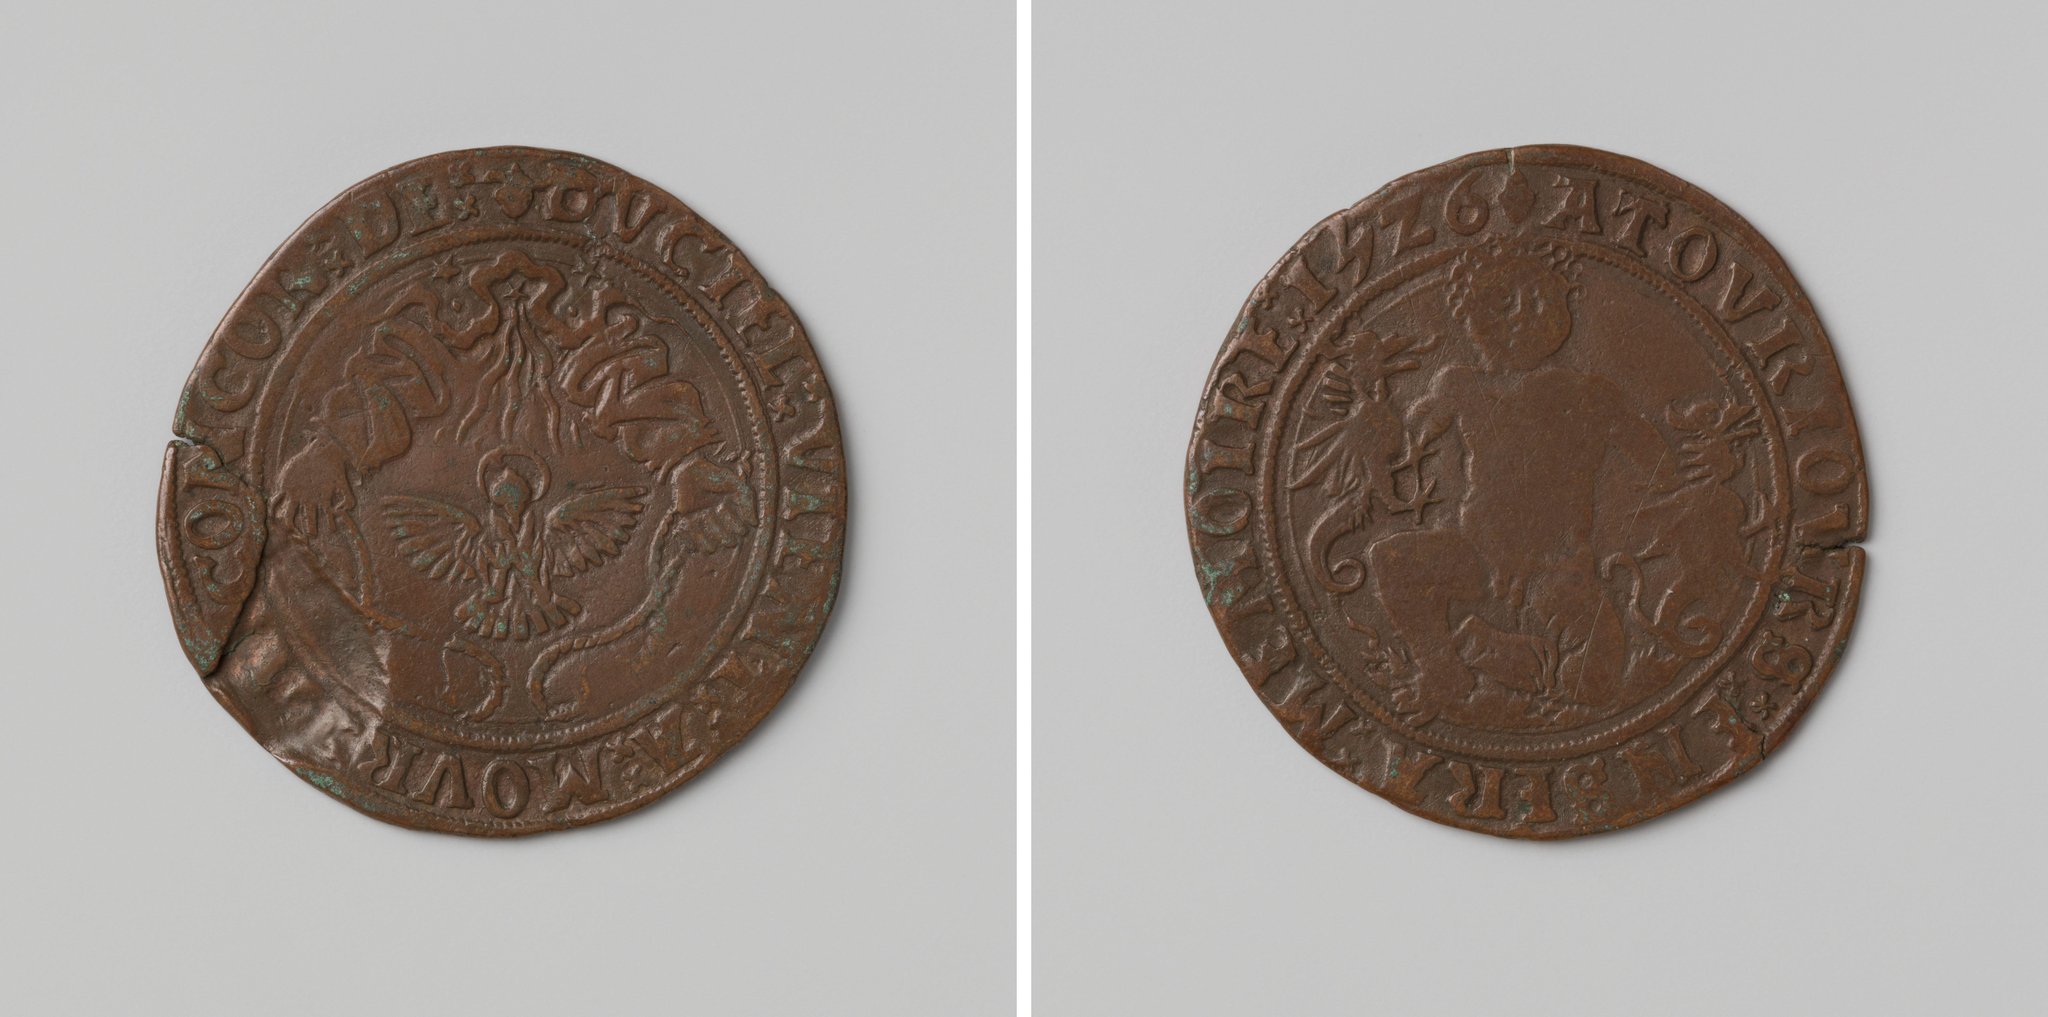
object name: jeton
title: Vrede van Madrid tussen Karel V, Duits keizer en Frans I, koning van Frankrijk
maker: Anonymous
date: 1526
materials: copper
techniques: striking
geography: netherlands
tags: frans i van valois-angoulême (koning van frankrijk), ghent, charles v (holy roman emperor and king of spain)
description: Koperen penning. Voorzijde: twee handen uit hemel houden elk een koord vast; daartussen duif met stralenkrans en gespreide vleugels. Keerzijde: naakt jongetje houdt in elk van beide handen gevleugeld draakje binnen omschrift